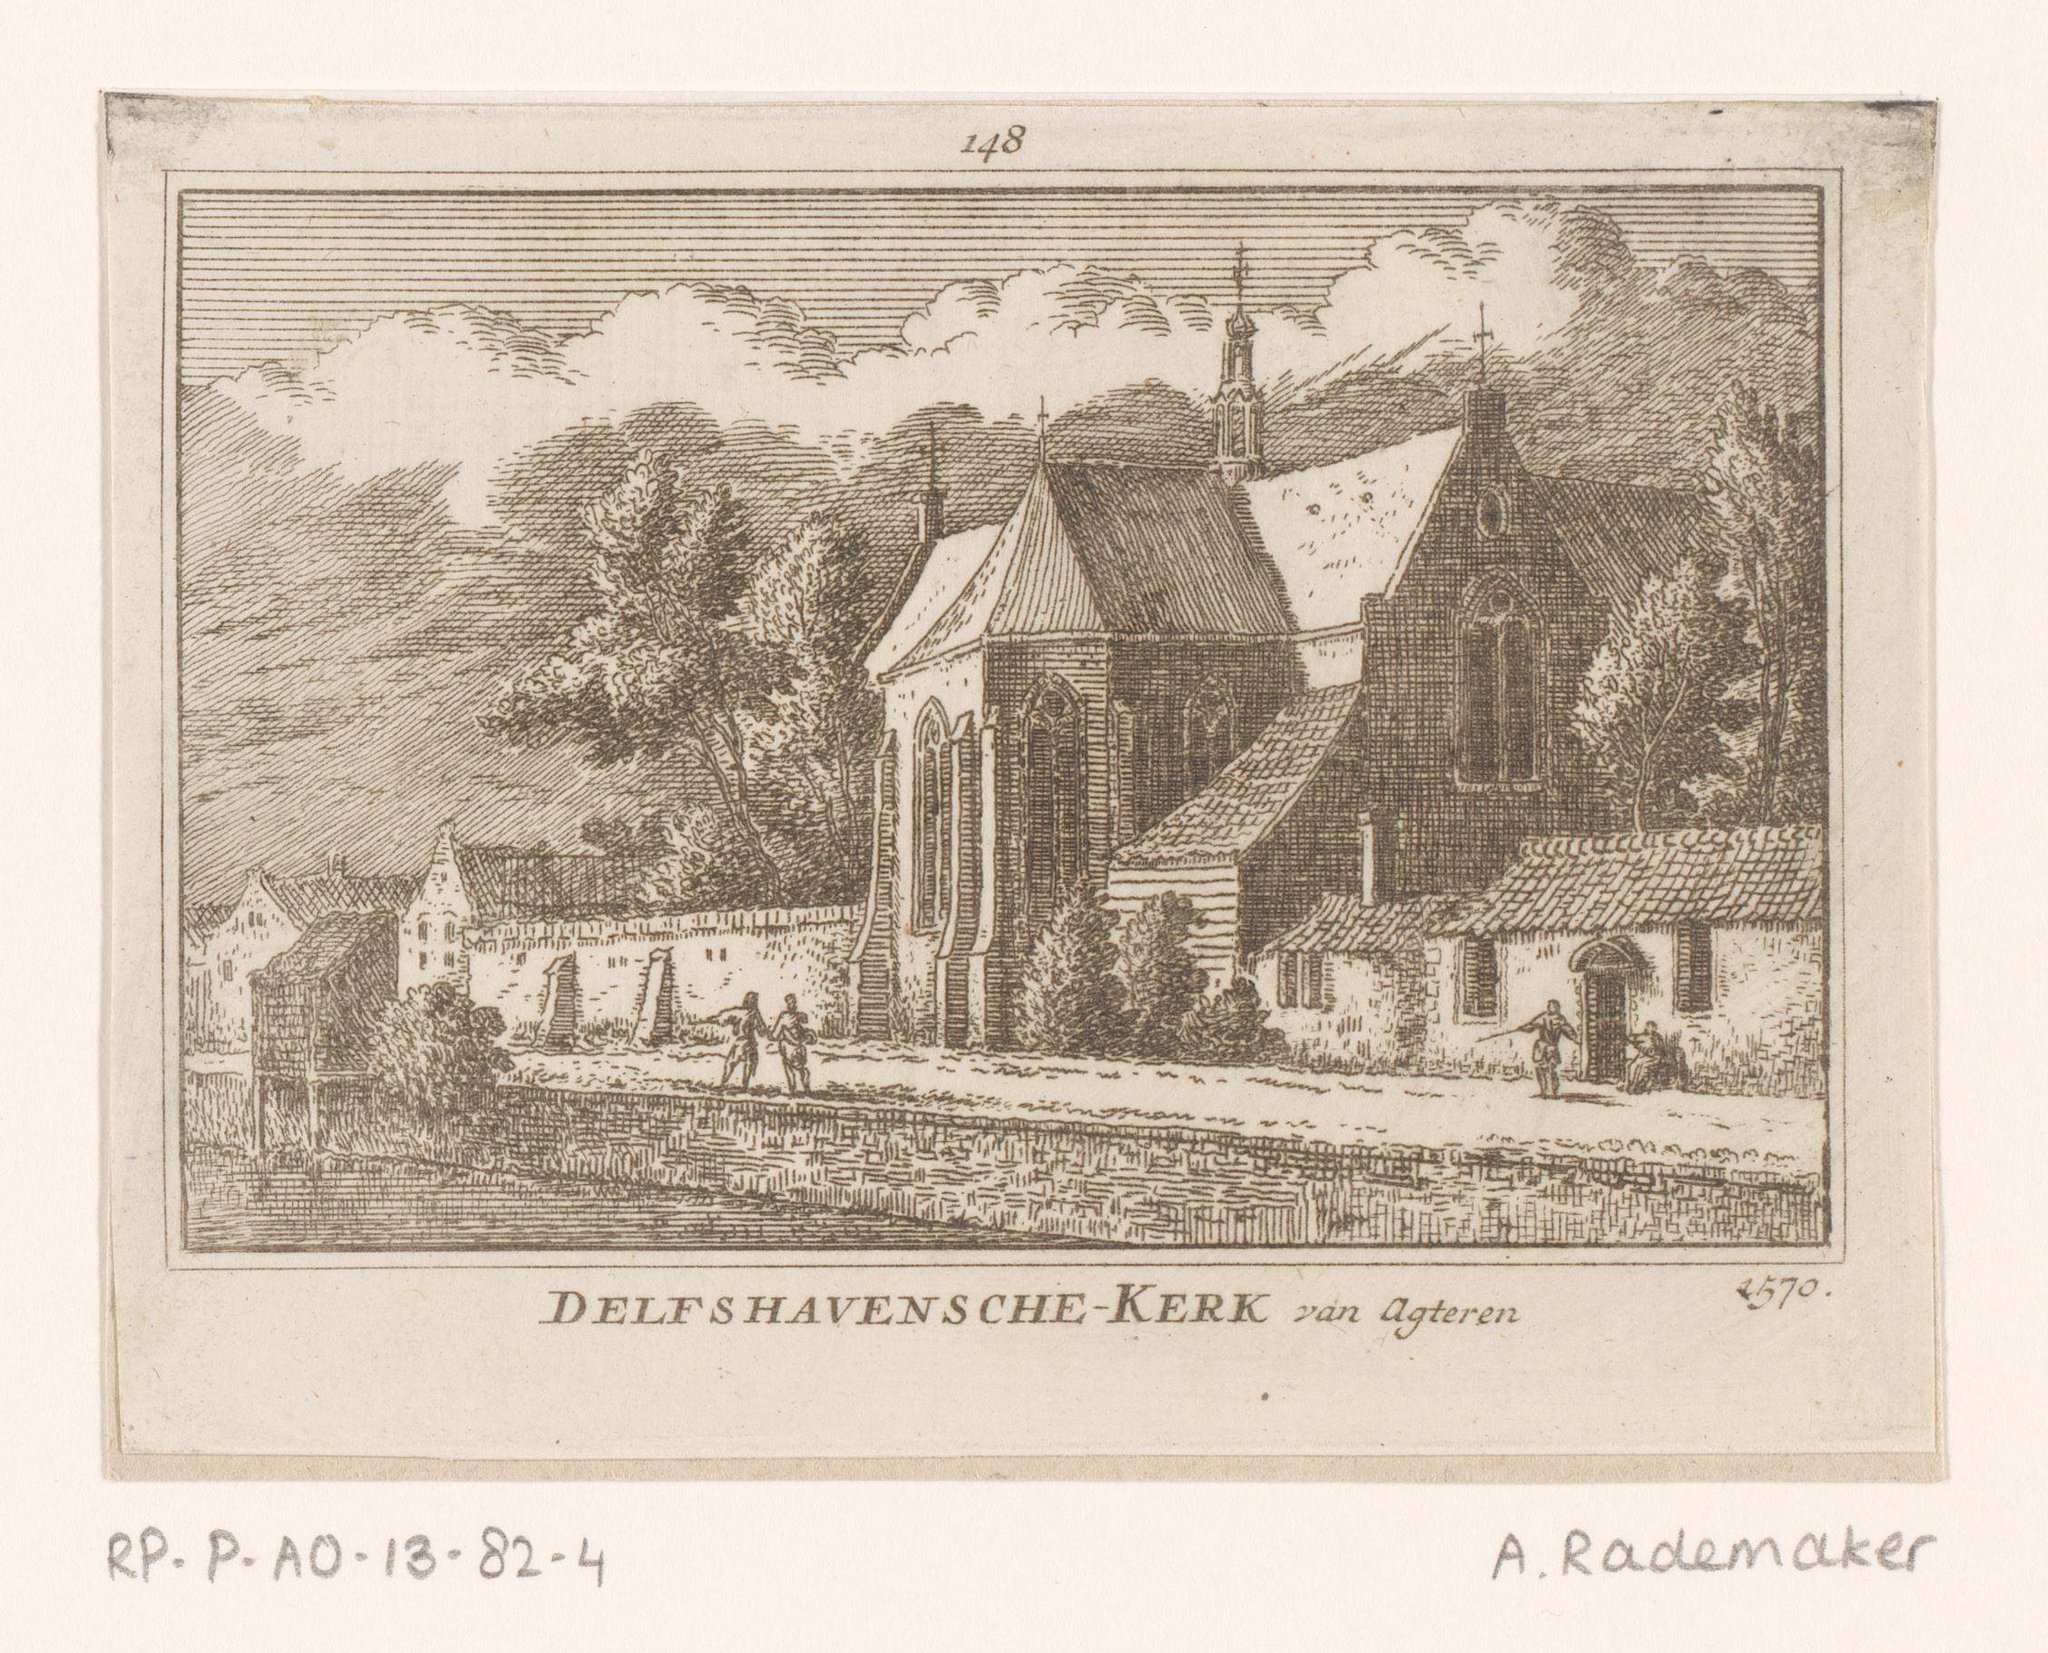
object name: print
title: Gezicht op de achterkant van de Oude of Pelgrimvaderskerk te Delfshaven, 1570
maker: abraham rademaker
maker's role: draughtsman, print maker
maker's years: 1676-1735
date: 1725-1803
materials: paper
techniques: engraving, etching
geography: amsterdam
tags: church (exterior), delfshaven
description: Prent ook gebruikt in: Rademaker, Abraham. Kabinet van Nederlandsche outheden en gezichten: vervat in 300 konstplaaten (…). 2 delen. Amsterdam: Willem Barents, 1725, dl. 1, ill. 148. Na 1725 is deze prent nog in verschillende heruitgaven verschenen, uitgegeven in 1727-1733, 1770-1771 en 1792-1803. Uit welke uitgave het huidige exemplaar precies komt is niet na te gaan.